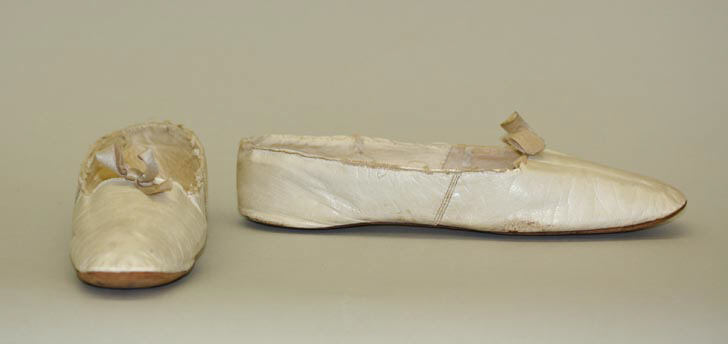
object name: slipper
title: Slippers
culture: american or european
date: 1801-1900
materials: leather